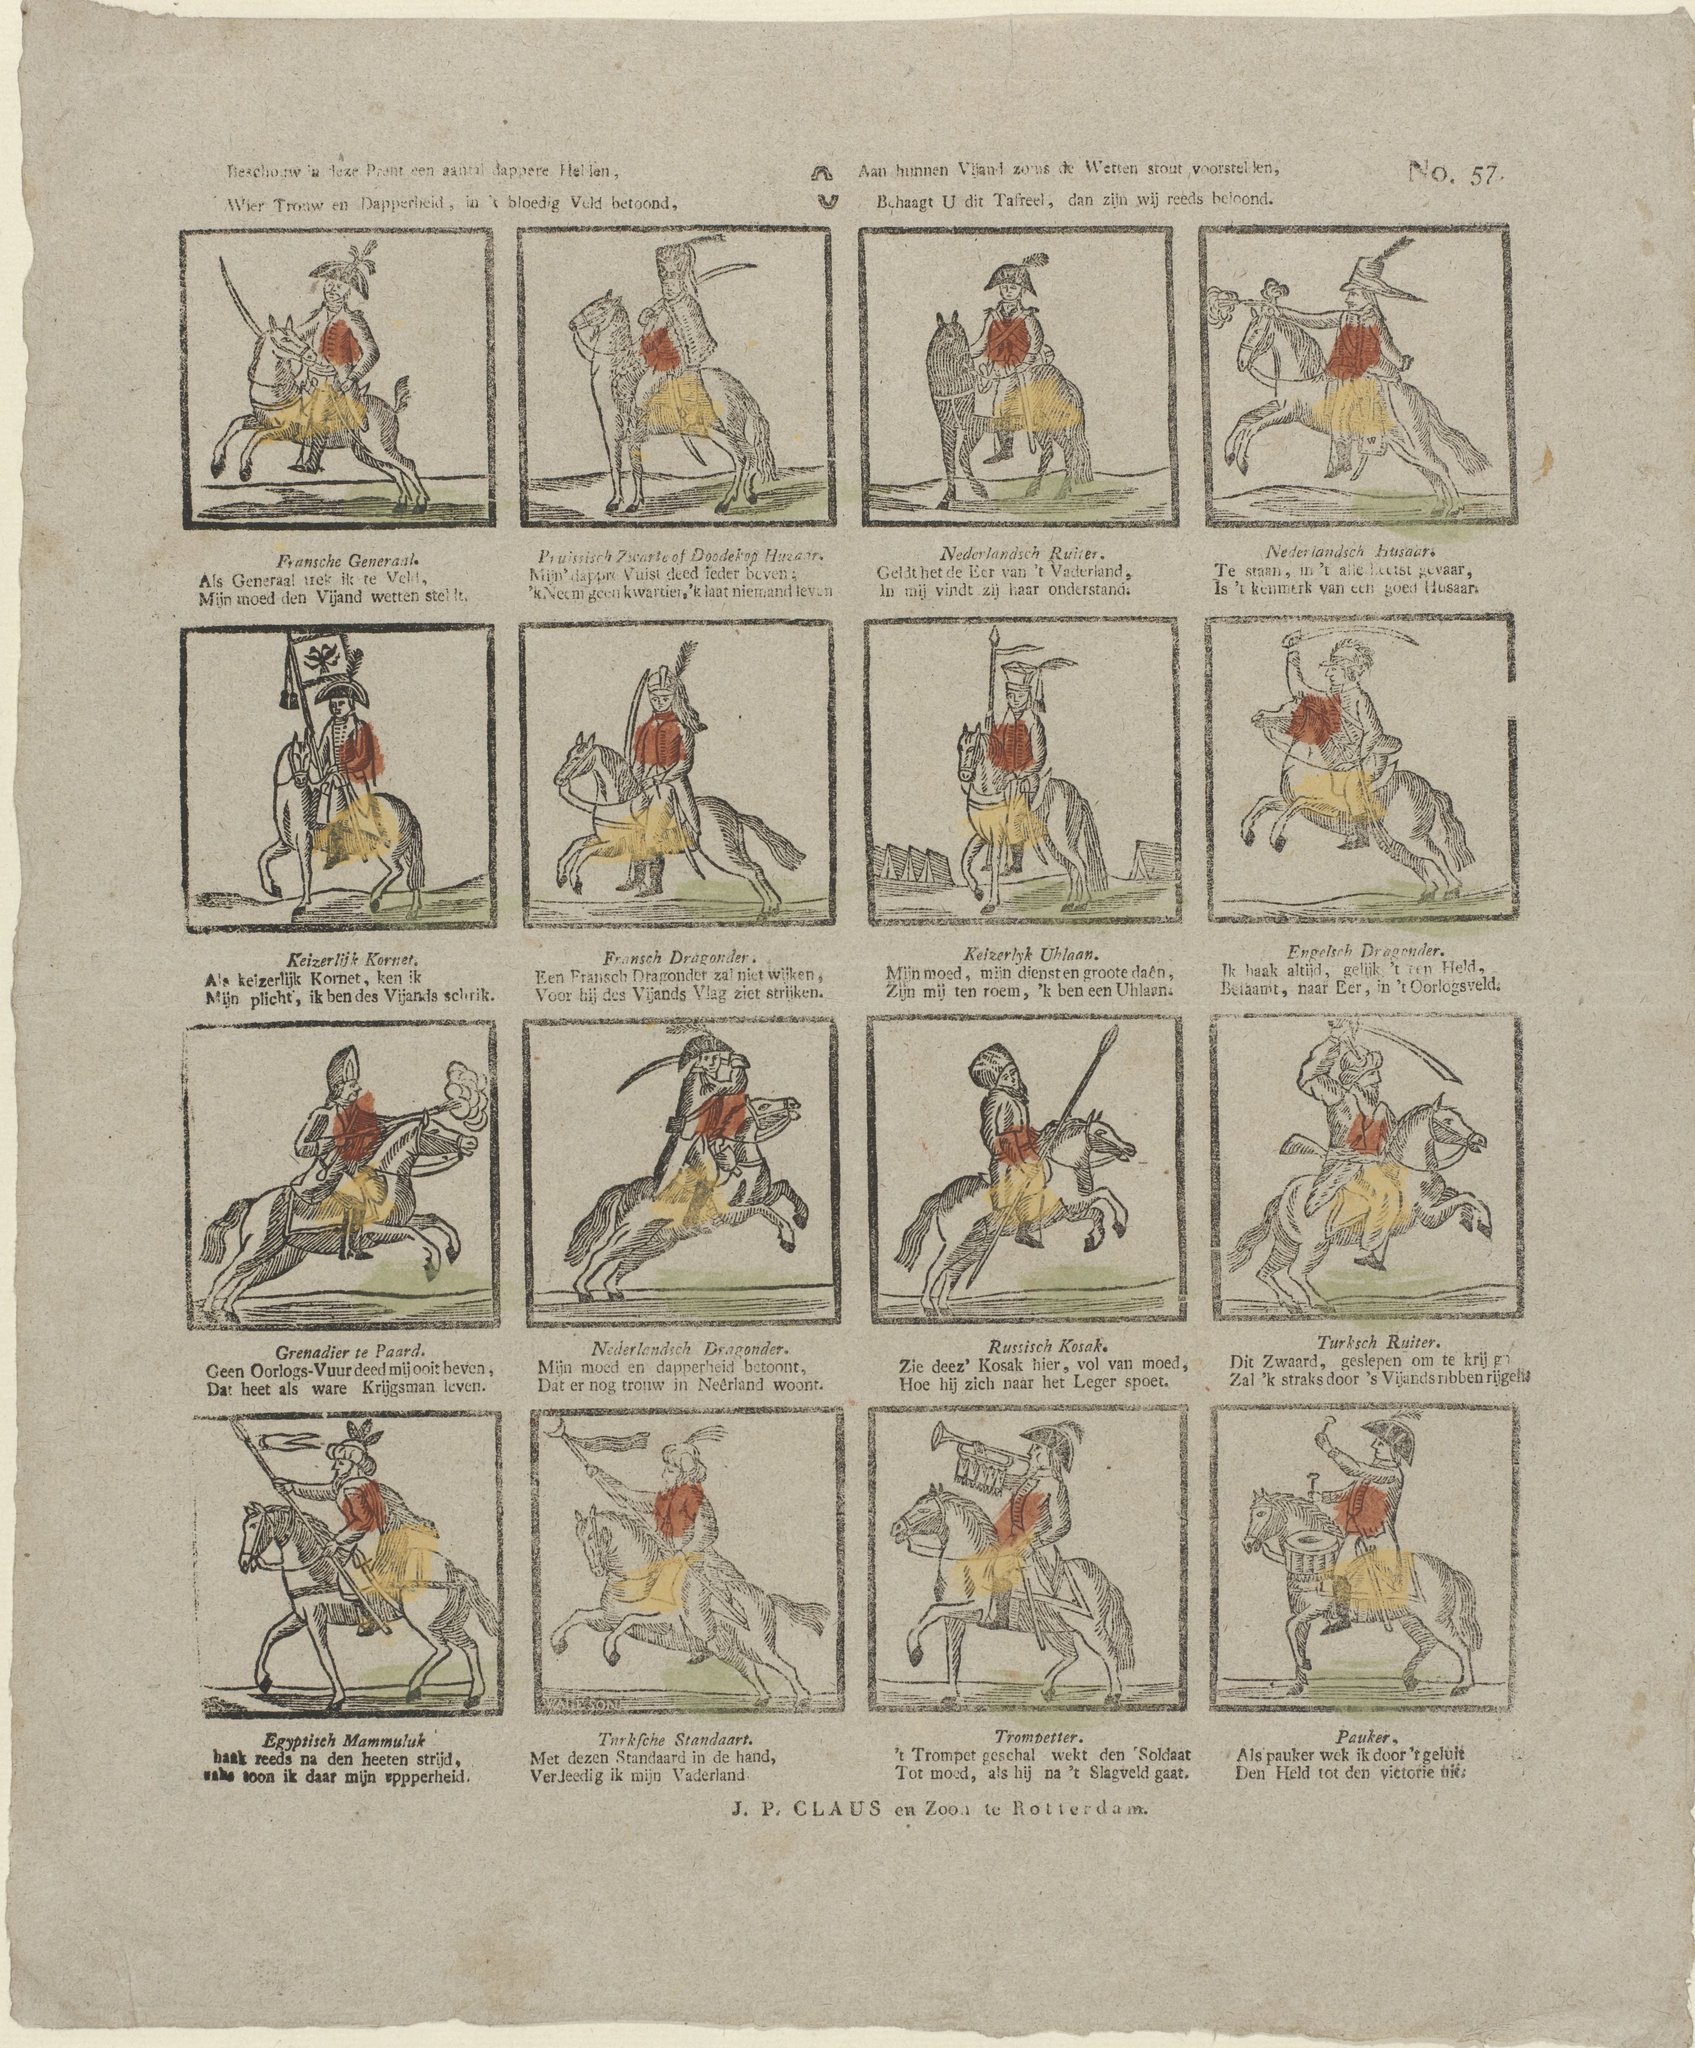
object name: print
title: Beschouw in deze prent een aantal dappere helden, / Wier trouw en dapperheid, in 't bloedig veld betoond, / Aan hunnen vijand soms de wetten stout voorstelde, / behaagt u dit tafereel, dan zyn wy reeds beloond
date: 1862-1905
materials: paper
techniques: colour, letterpress printing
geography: breda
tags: riding a horse, ass, or mule; rider, horseman, weapons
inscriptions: collector's mark: Lugt 2760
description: Blad met 16 voorstellingen van militairen te paard. Onder elke afbeelding een naam en tweeregelig vers. Genummerd rechtsboven: No. 57.